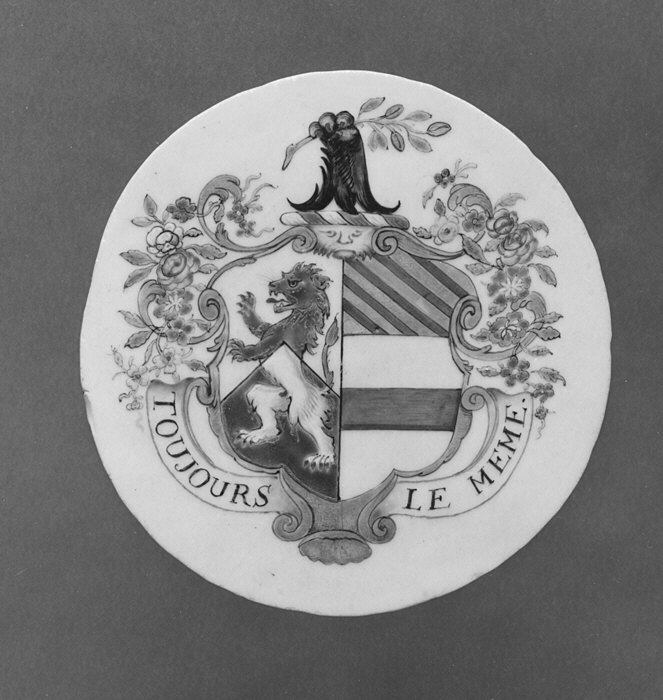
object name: roundel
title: Roundel (plate center)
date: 1745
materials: hard paste porcelain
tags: birds,flowers,leaves,coat of arms